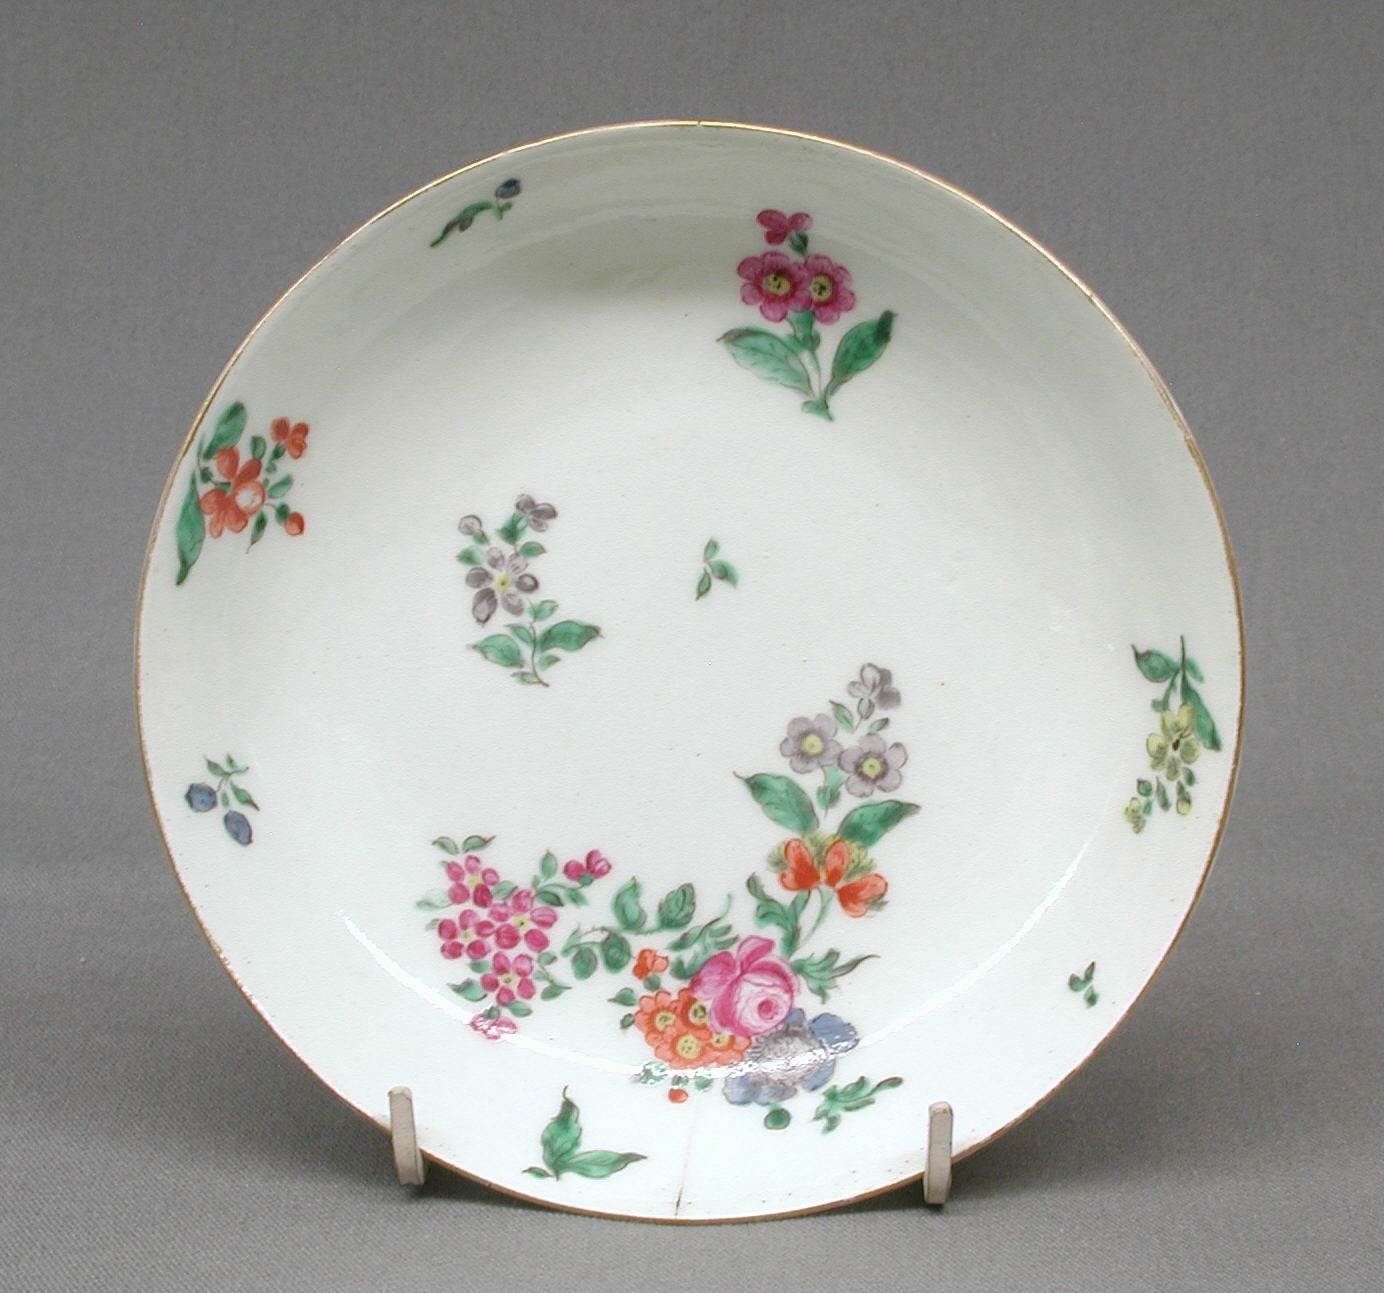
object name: saucer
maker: worcester factory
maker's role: factory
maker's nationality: british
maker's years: 1751-2008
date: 1760-1770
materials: soft paste porcelain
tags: flowers